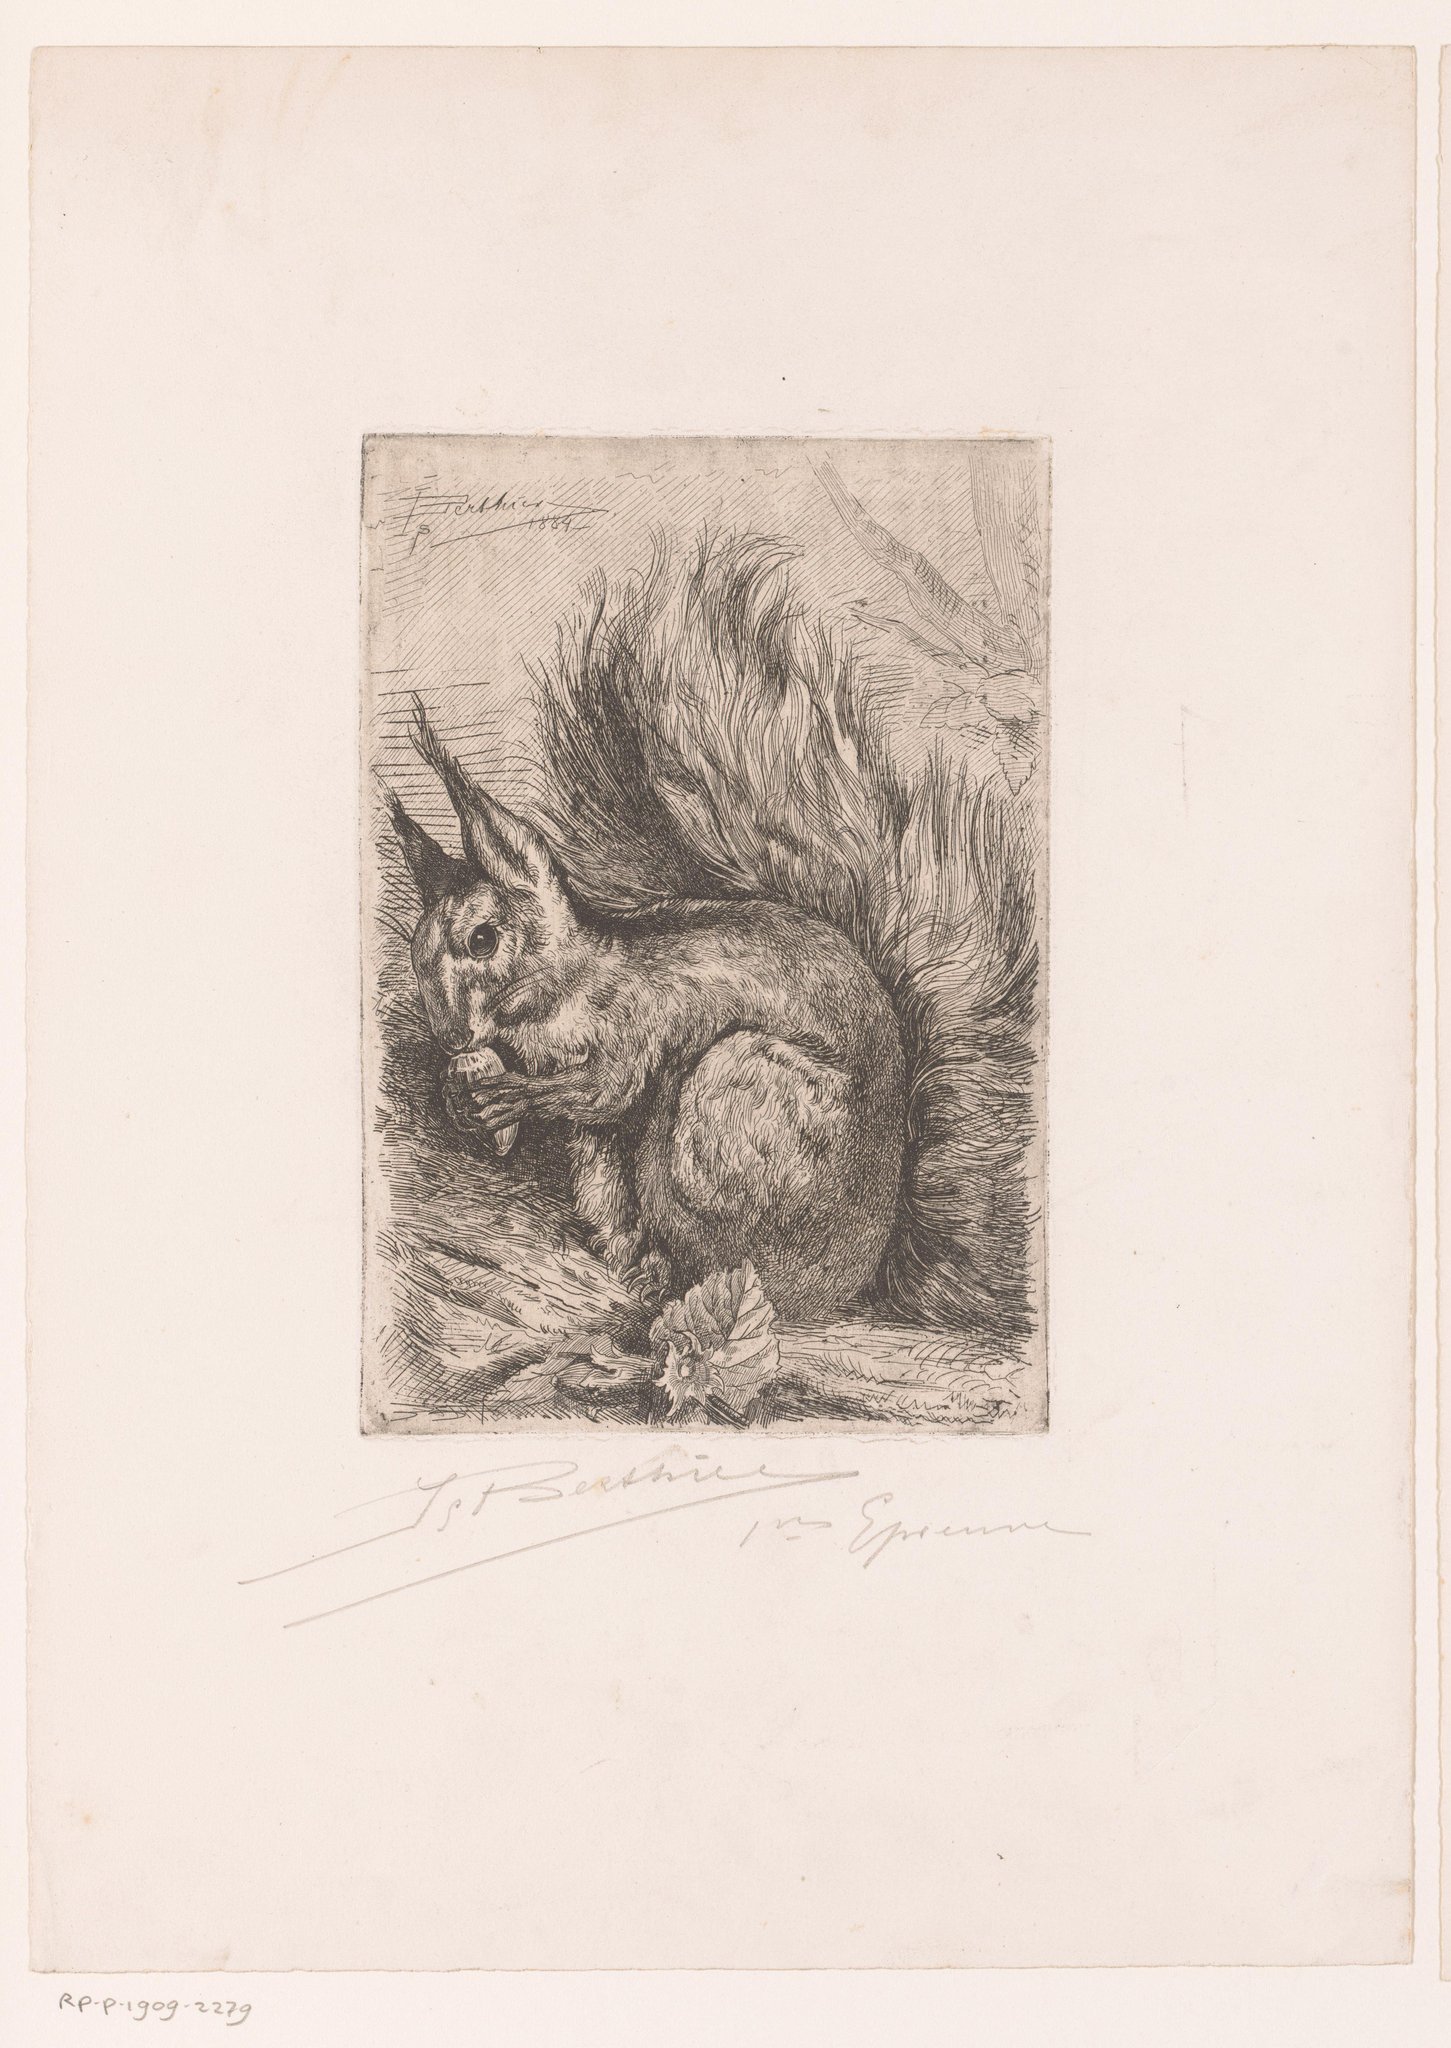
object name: print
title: Eekhoorn met hazelnoot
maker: h. berthier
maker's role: print maker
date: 1884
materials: paper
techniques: etching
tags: rodents: squirrel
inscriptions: inscription: ‘1e Epreuve’, collector's mark: Lugt 2228